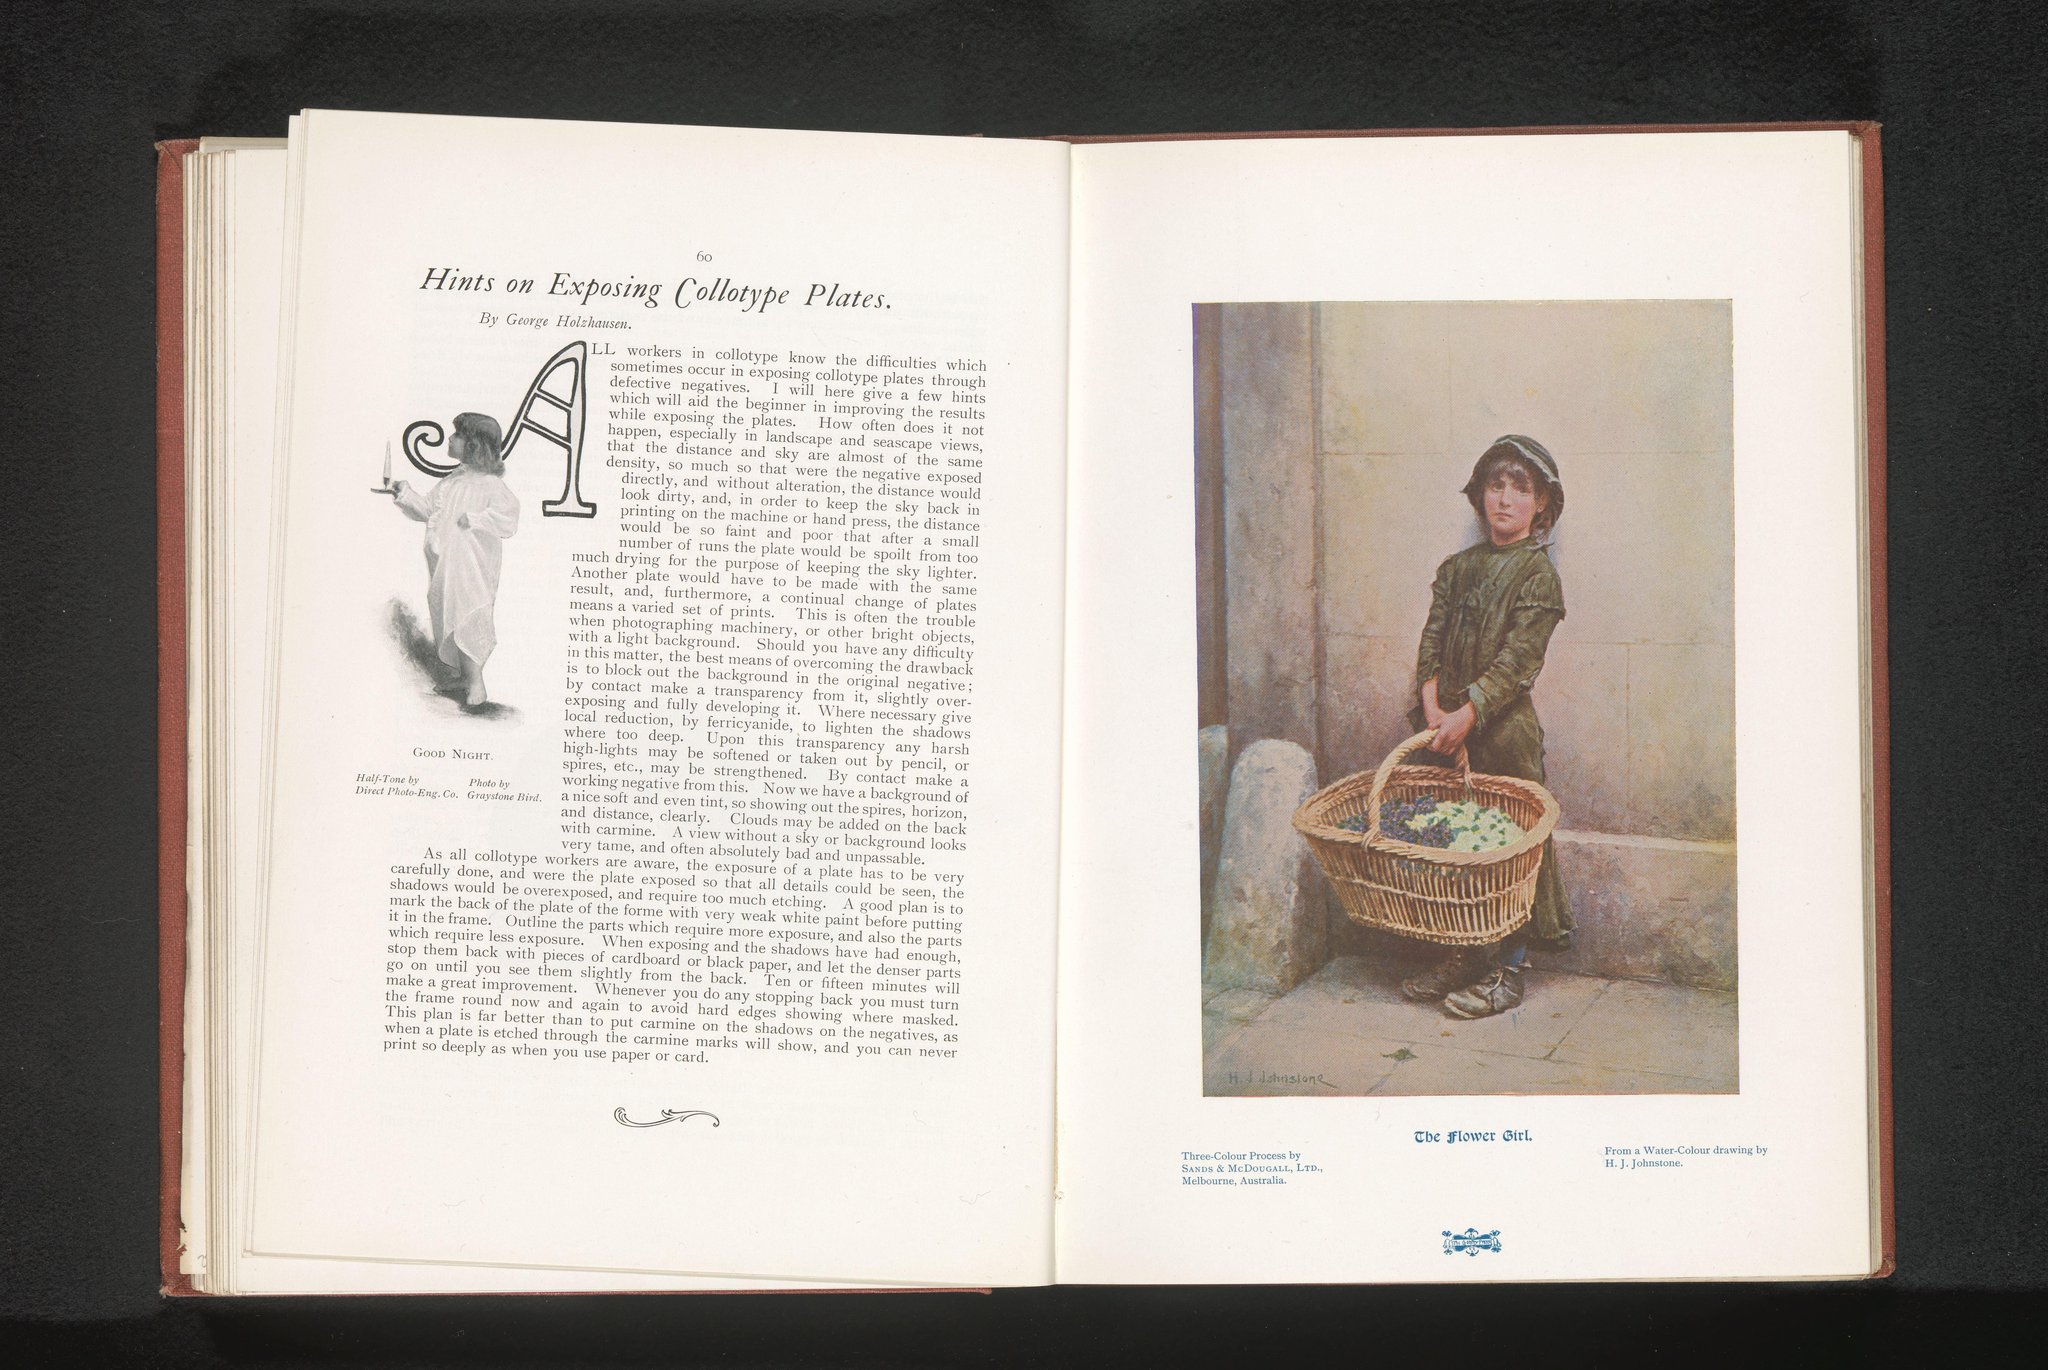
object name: photomechanical print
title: Reproductie van een aquarel van een meisje met een mand met bloemen door H.J. Johnstone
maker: henry james johnstone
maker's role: painter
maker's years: 1835-1907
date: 1895-1900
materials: paper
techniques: three-color autotype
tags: flowers, girl (child between toddler and youth)